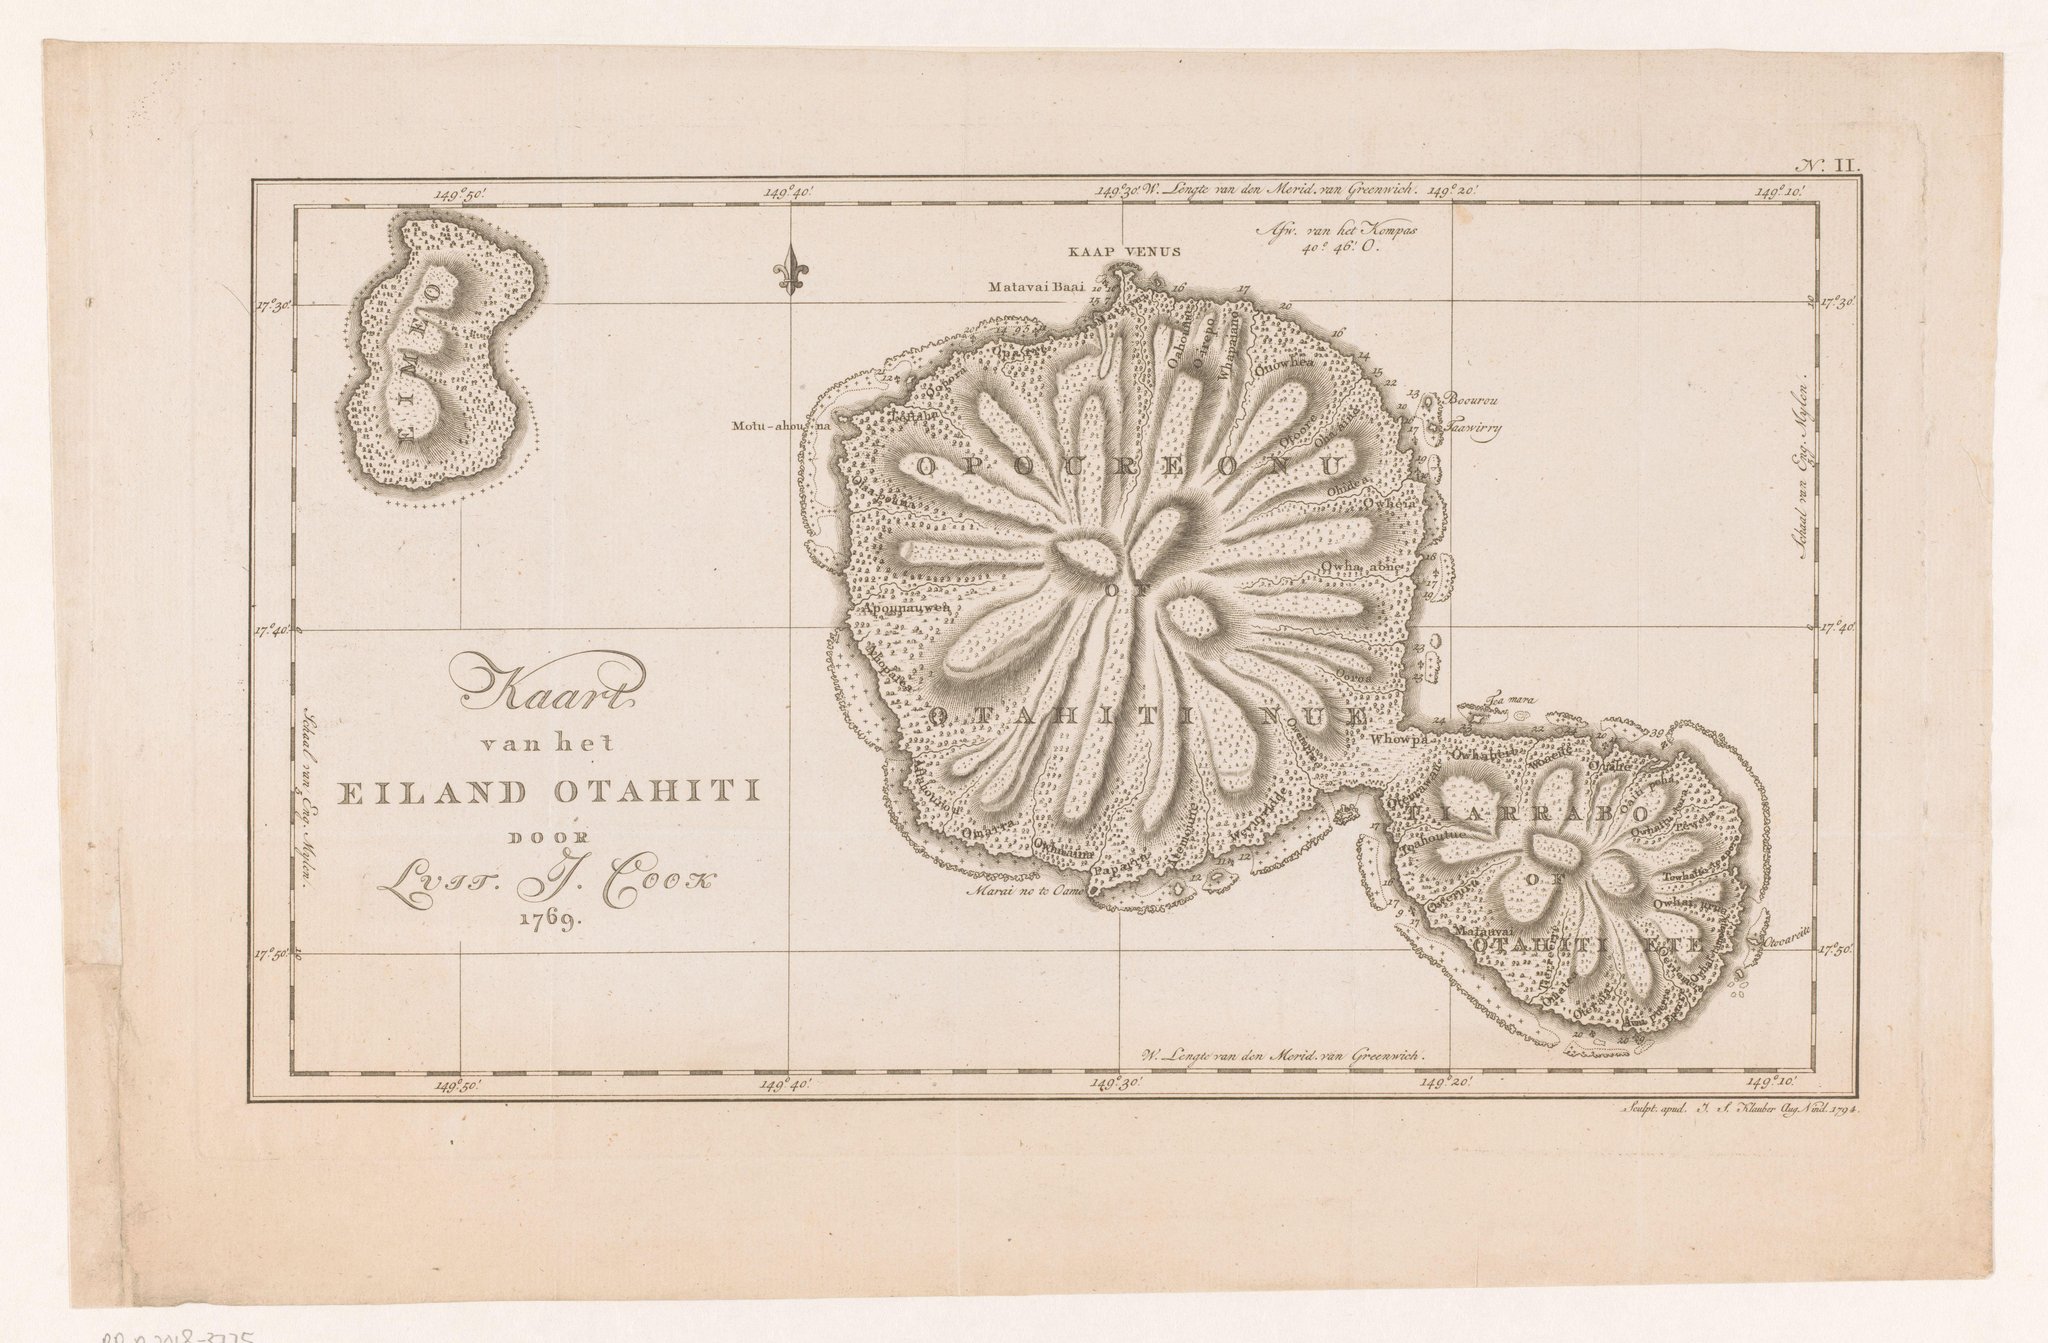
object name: book illustration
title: Kaart van het eiland Otahiti door Luit. J. Cook 1769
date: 1794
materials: paper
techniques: etching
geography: the hague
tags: island, maps, atlases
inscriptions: collector's mark: Lugt 2228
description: Prent uit: Cook, James. Reize rondom de Waereld (...) met kaarten en plaaten. [Vertaald uit het Engels door] Jan David Pasteur. Leiden: Honkoop, Amsterdam: Allart, Den Haag: Van Cleef, 1795, dl. 1, p. 124.